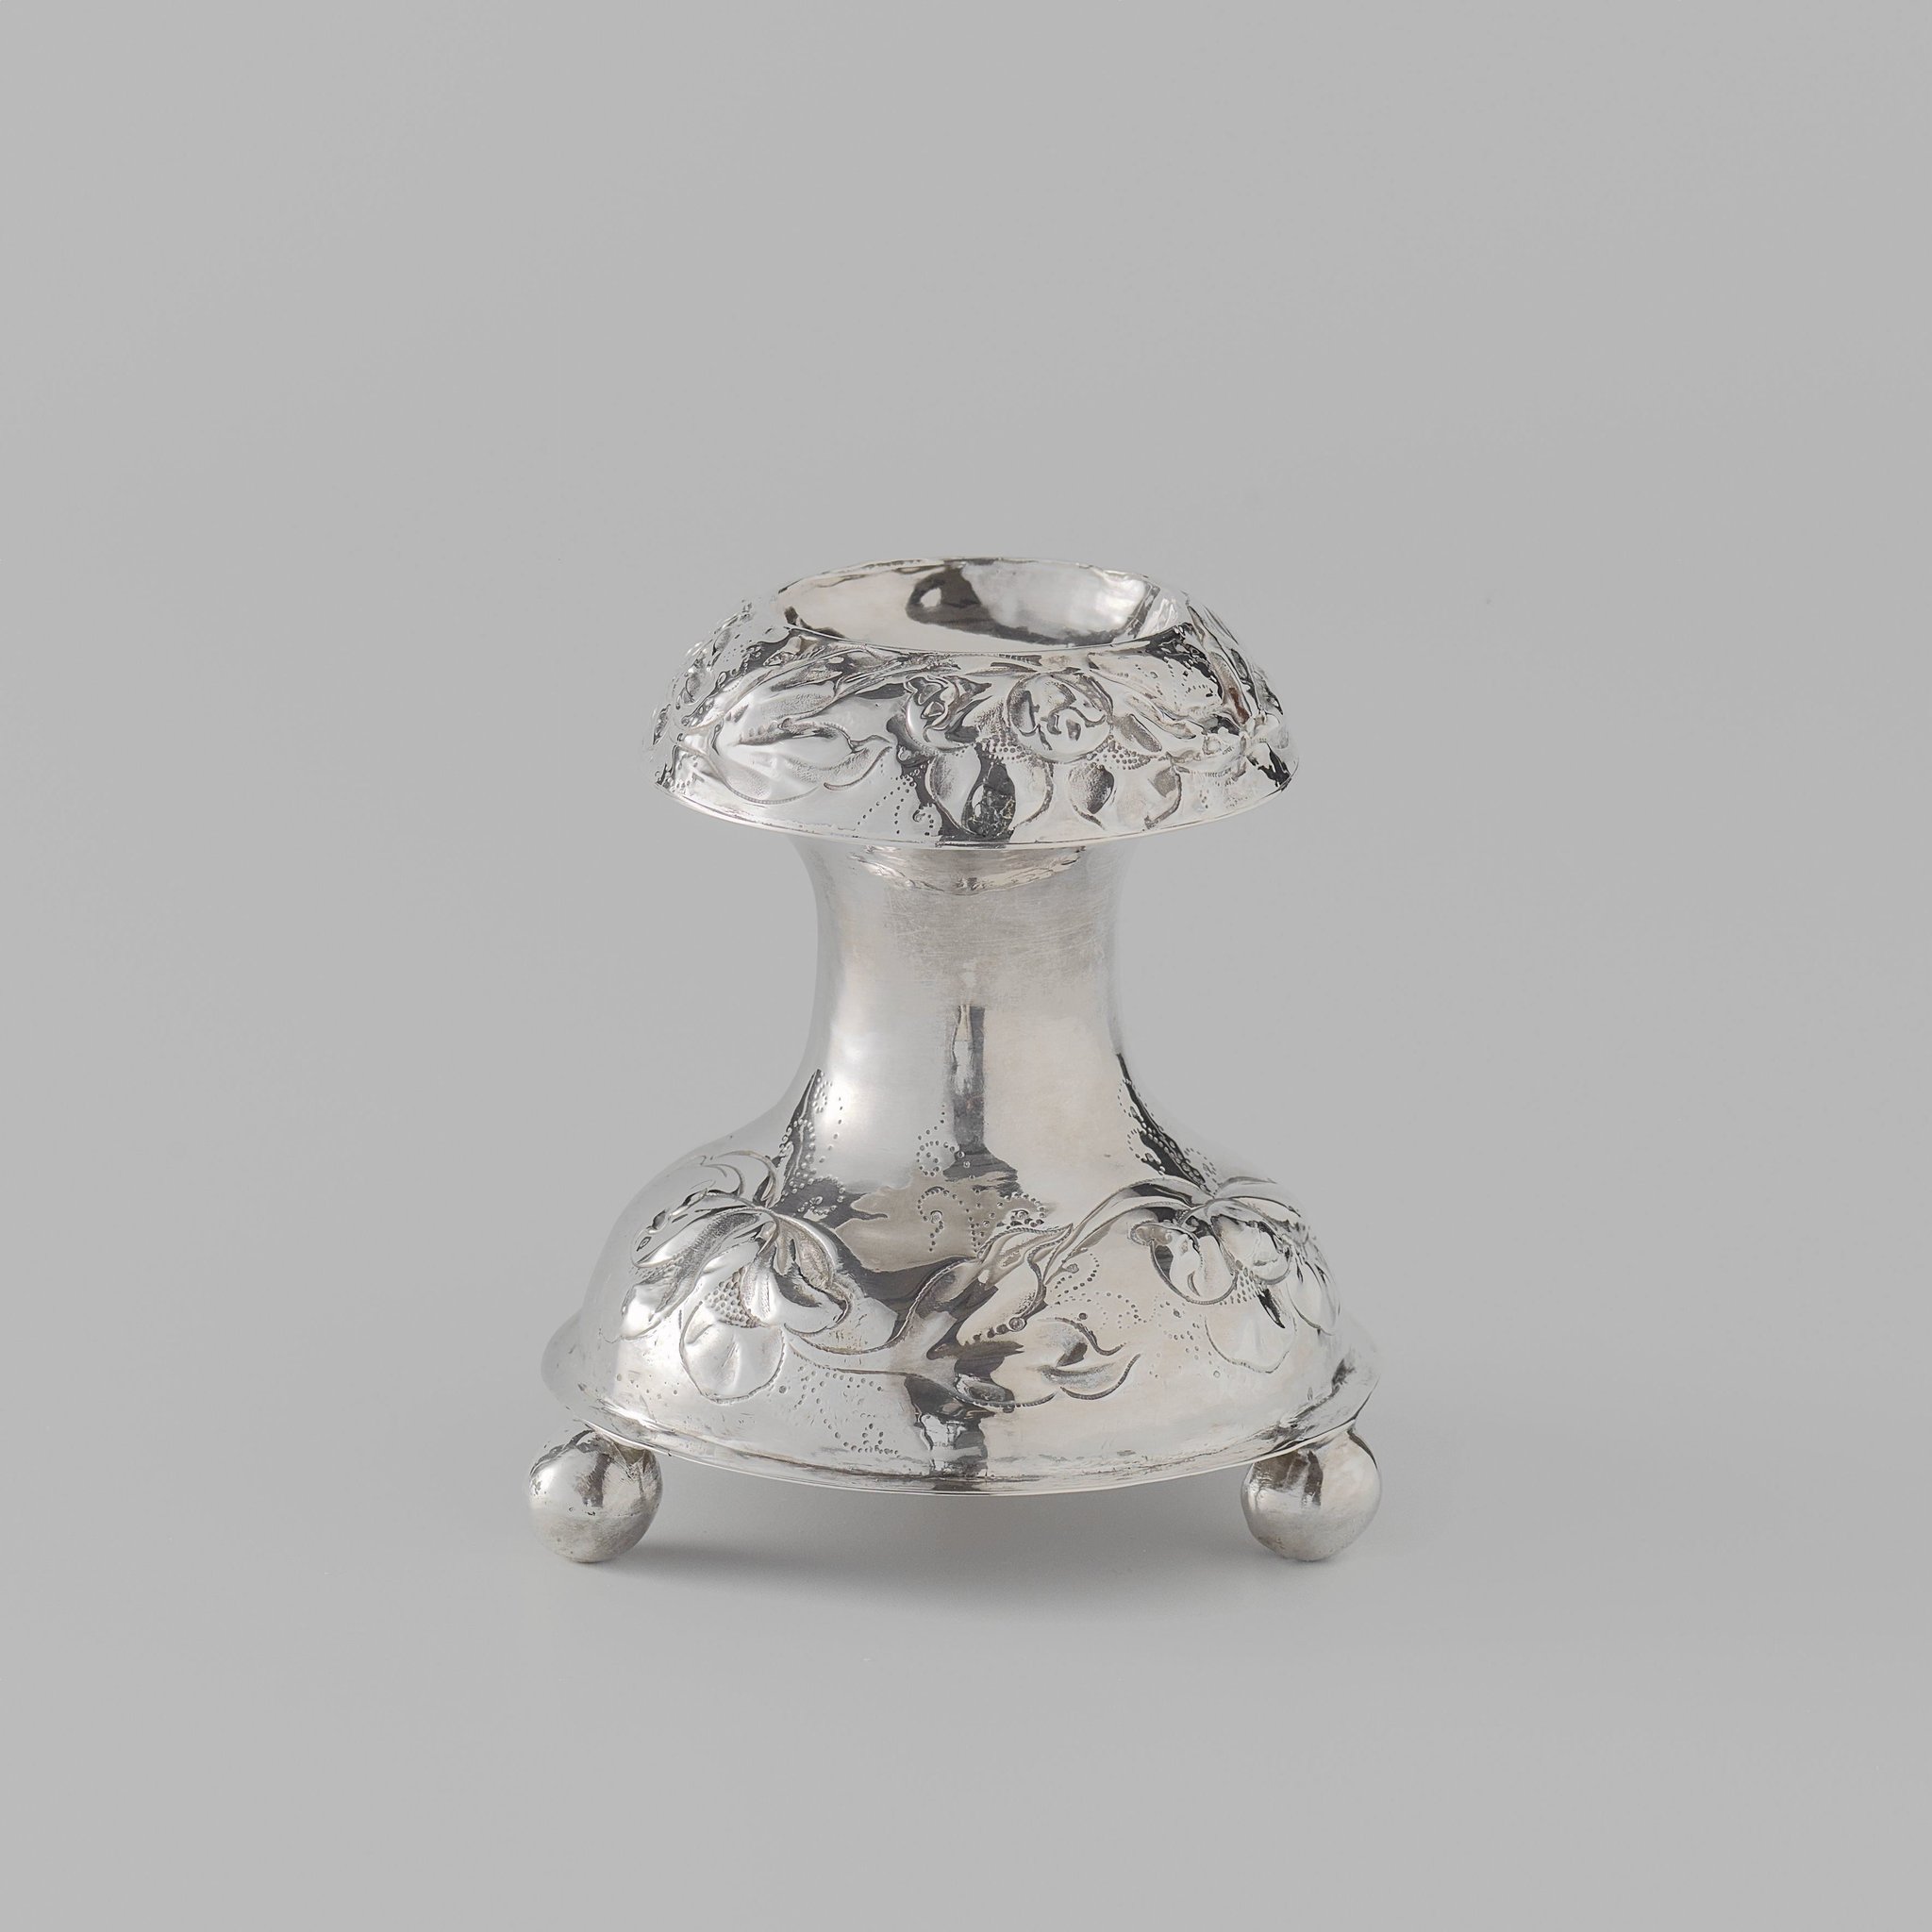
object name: salt condiment vessel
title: Zoutvat in diabolovorm op gewelfde voet met drie bolpoten. Voet en rand met gedreven bloemen en bladeren.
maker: Anonymous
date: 1680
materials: silver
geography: middelburg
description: Diabolo-vormig zoutvat van zilver, rustend op drie bolpootjes. De brede, gewelfde voet gaat geleidelijk over in een bolle omgeslagen rand met komvormig midden. Voet en rand versierd met gedreven bloemen en bladeren.